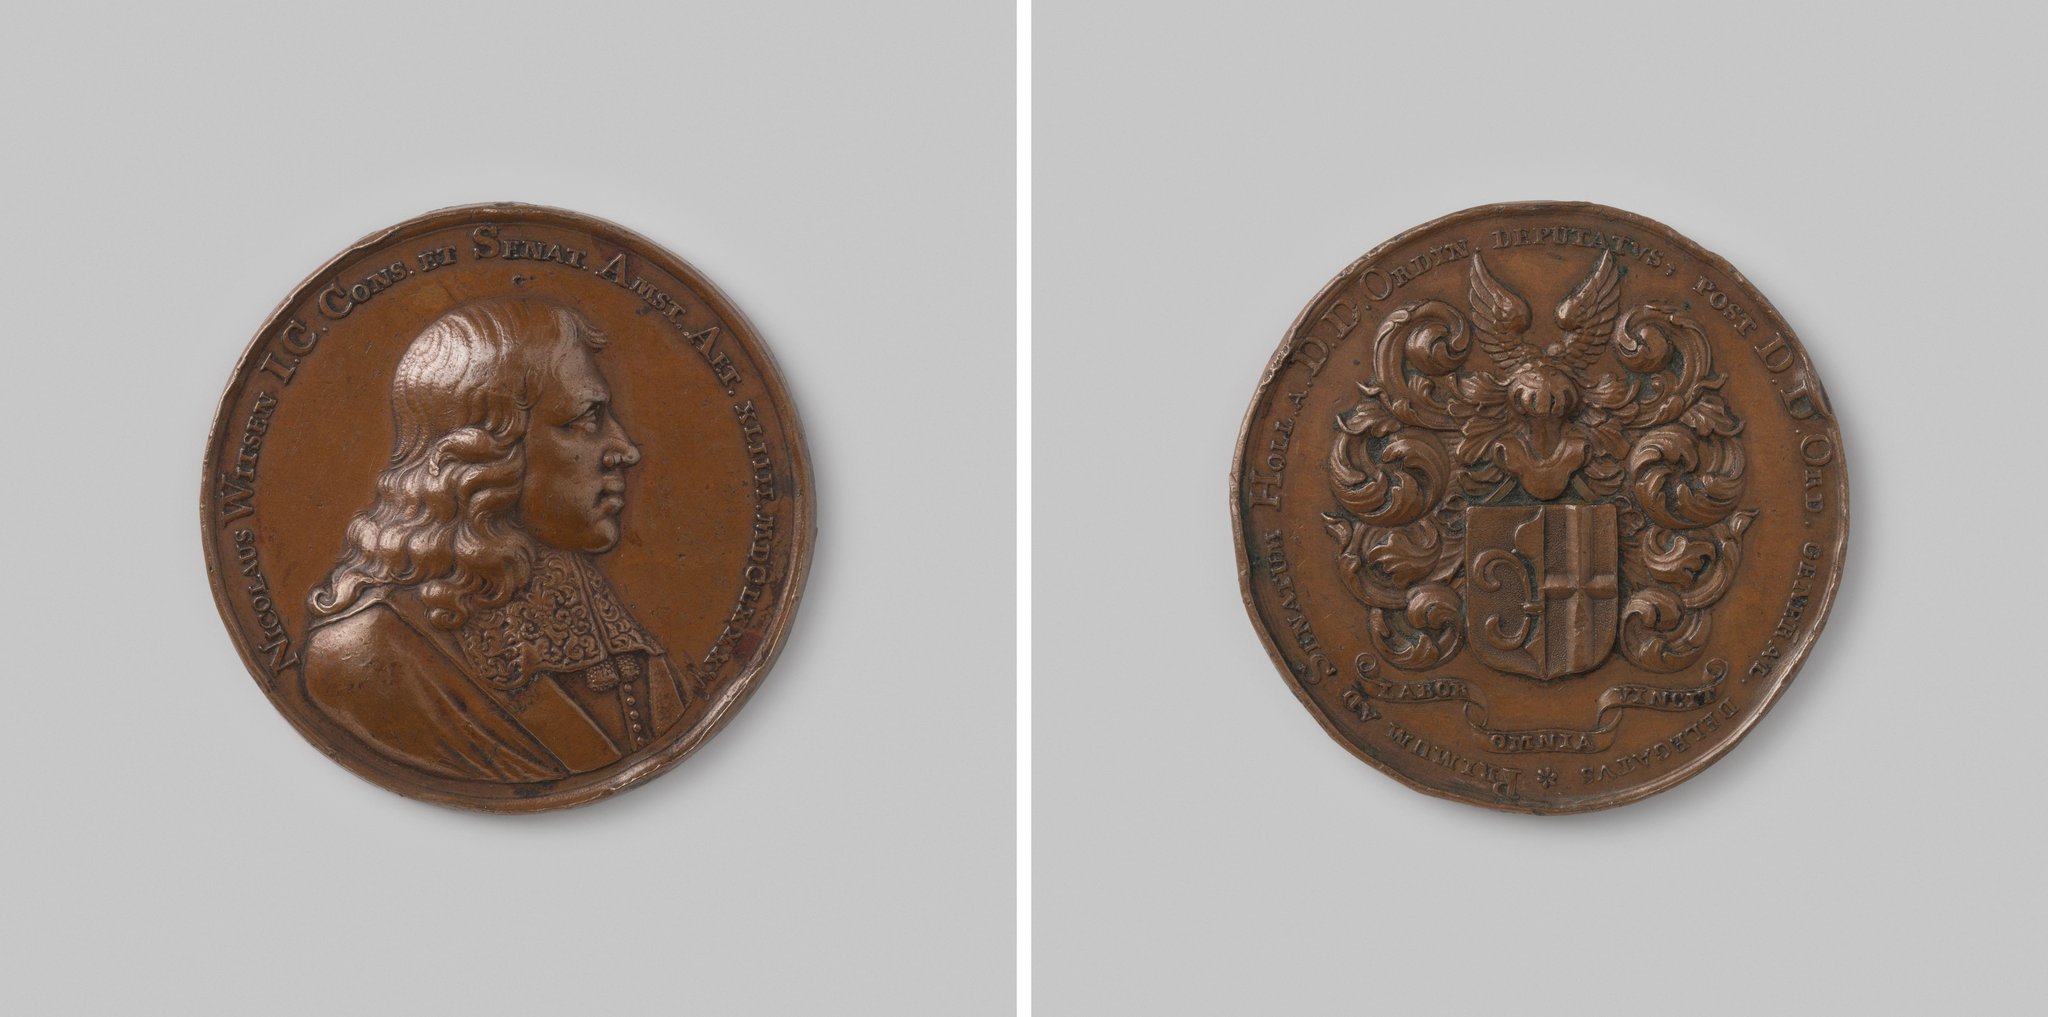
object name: history medal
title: Nicolaas Witsen burgemeester van Amsterdam 1685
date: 1685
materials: copper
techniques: striking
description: Koperen penning, op de voorzijde het borstbeeld van Witsen naar rechts met omschrift, op de keerzijde een gehelmd wapenschild boven een lint, met omschrift.